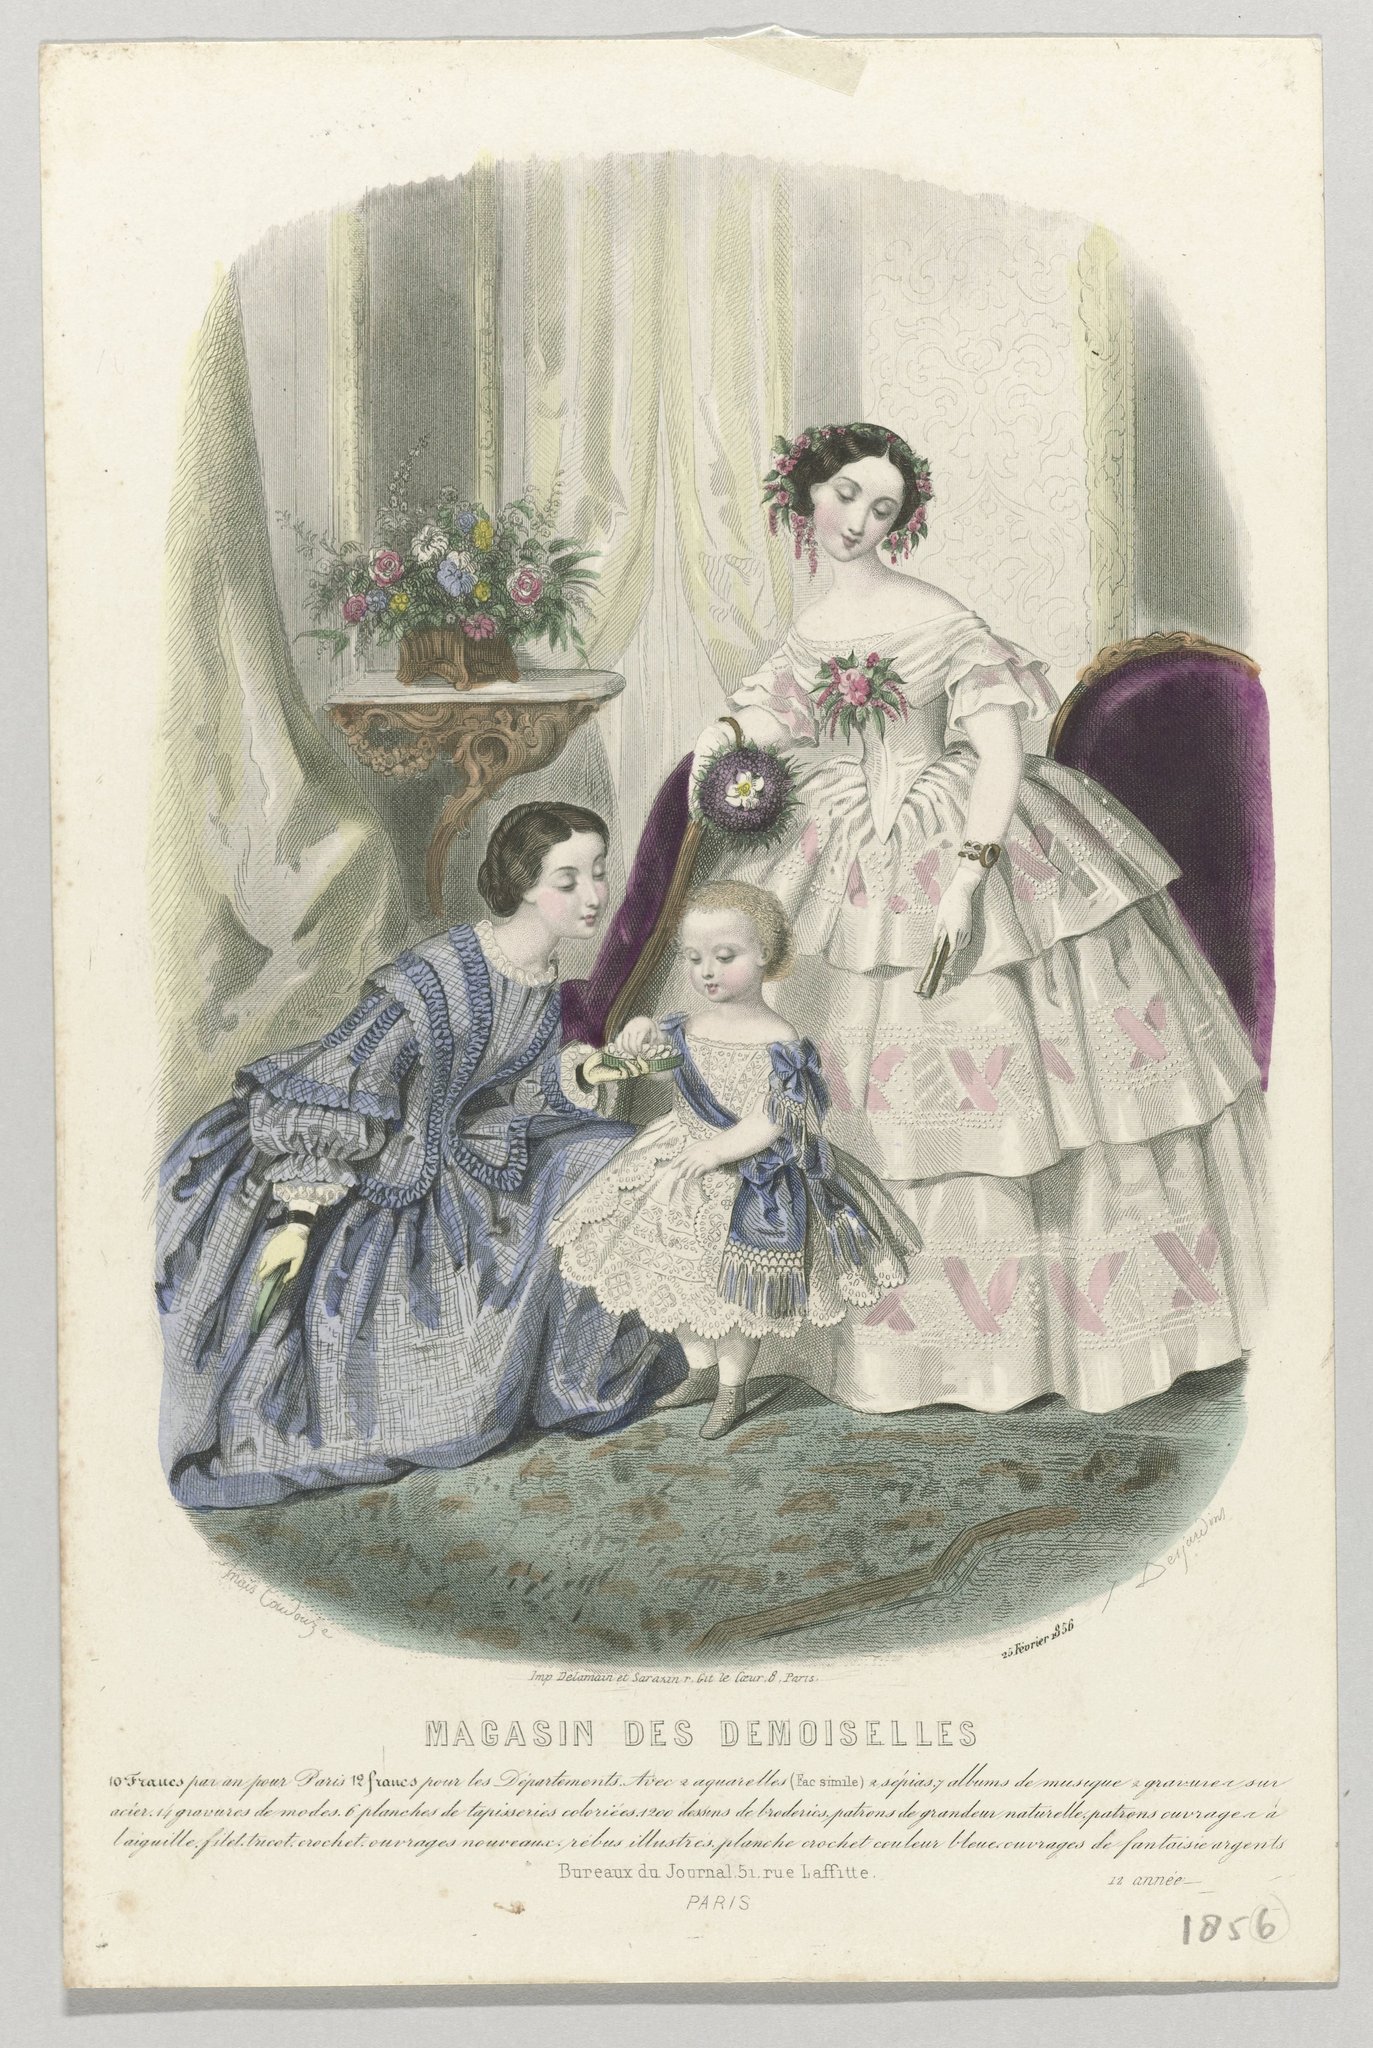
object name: fashion print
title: Magasin des Demoiselles, 25 février 1856, 12 année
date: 1856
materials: paper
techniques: hand coloring, engraving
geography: paris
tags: clothes, costume (+ girls' clothes), gloves, mittens (short gloves) (+ women's clothes), head-gear (+ women's clothes), medicinal spring, fashion plates, fan (+ women's clothes), neck-gear ~ clothing (+ women's clothes), bracelet, wristlet (+ women's clothes)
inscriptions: title: ‘Magasin des Demoiselles’, address: ‘Bureaux du Journal, 51, rue Laffitte. / Paris’, caption: ‘10 Francs par an pour Paris 12 francs pour les Départements, Avec 2 Aquarelles (fac simile) 2 sépias, 7 albums de musique, 2 gravures sur acier, 14 gravures de modes, 6 planches de tapisseries coloriées, 1200 dessins de broderies, patrons de grandeur naturelle, petits patrons, ouvrages à l'aiguille, filet, tricot, crochet ouvrages nouveaux, rébus illustrés. planches crochet, couleur bleue: planche de petits ouvrages fantaisie argents.’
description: Een vrouw, met geopend doosje in de hand, knielt naast een meisje in een witte japon met sjerp. Achter haar staat een vrouw met een boeket bloemen in de hand. Links: paarse geruite japon versierd met donkerpaars band. Rechts: witte japon met boothals, korte mouwen en puntig lijfje. Accessoires: bloemcorsage, handschoenen, armbanden om beide polsen, waaier. Onder de voorstelling enkele regels informatie over het modetijdschrift. Prent uit het modetijdschrift Magasin des Demoiselles (1844-1896).